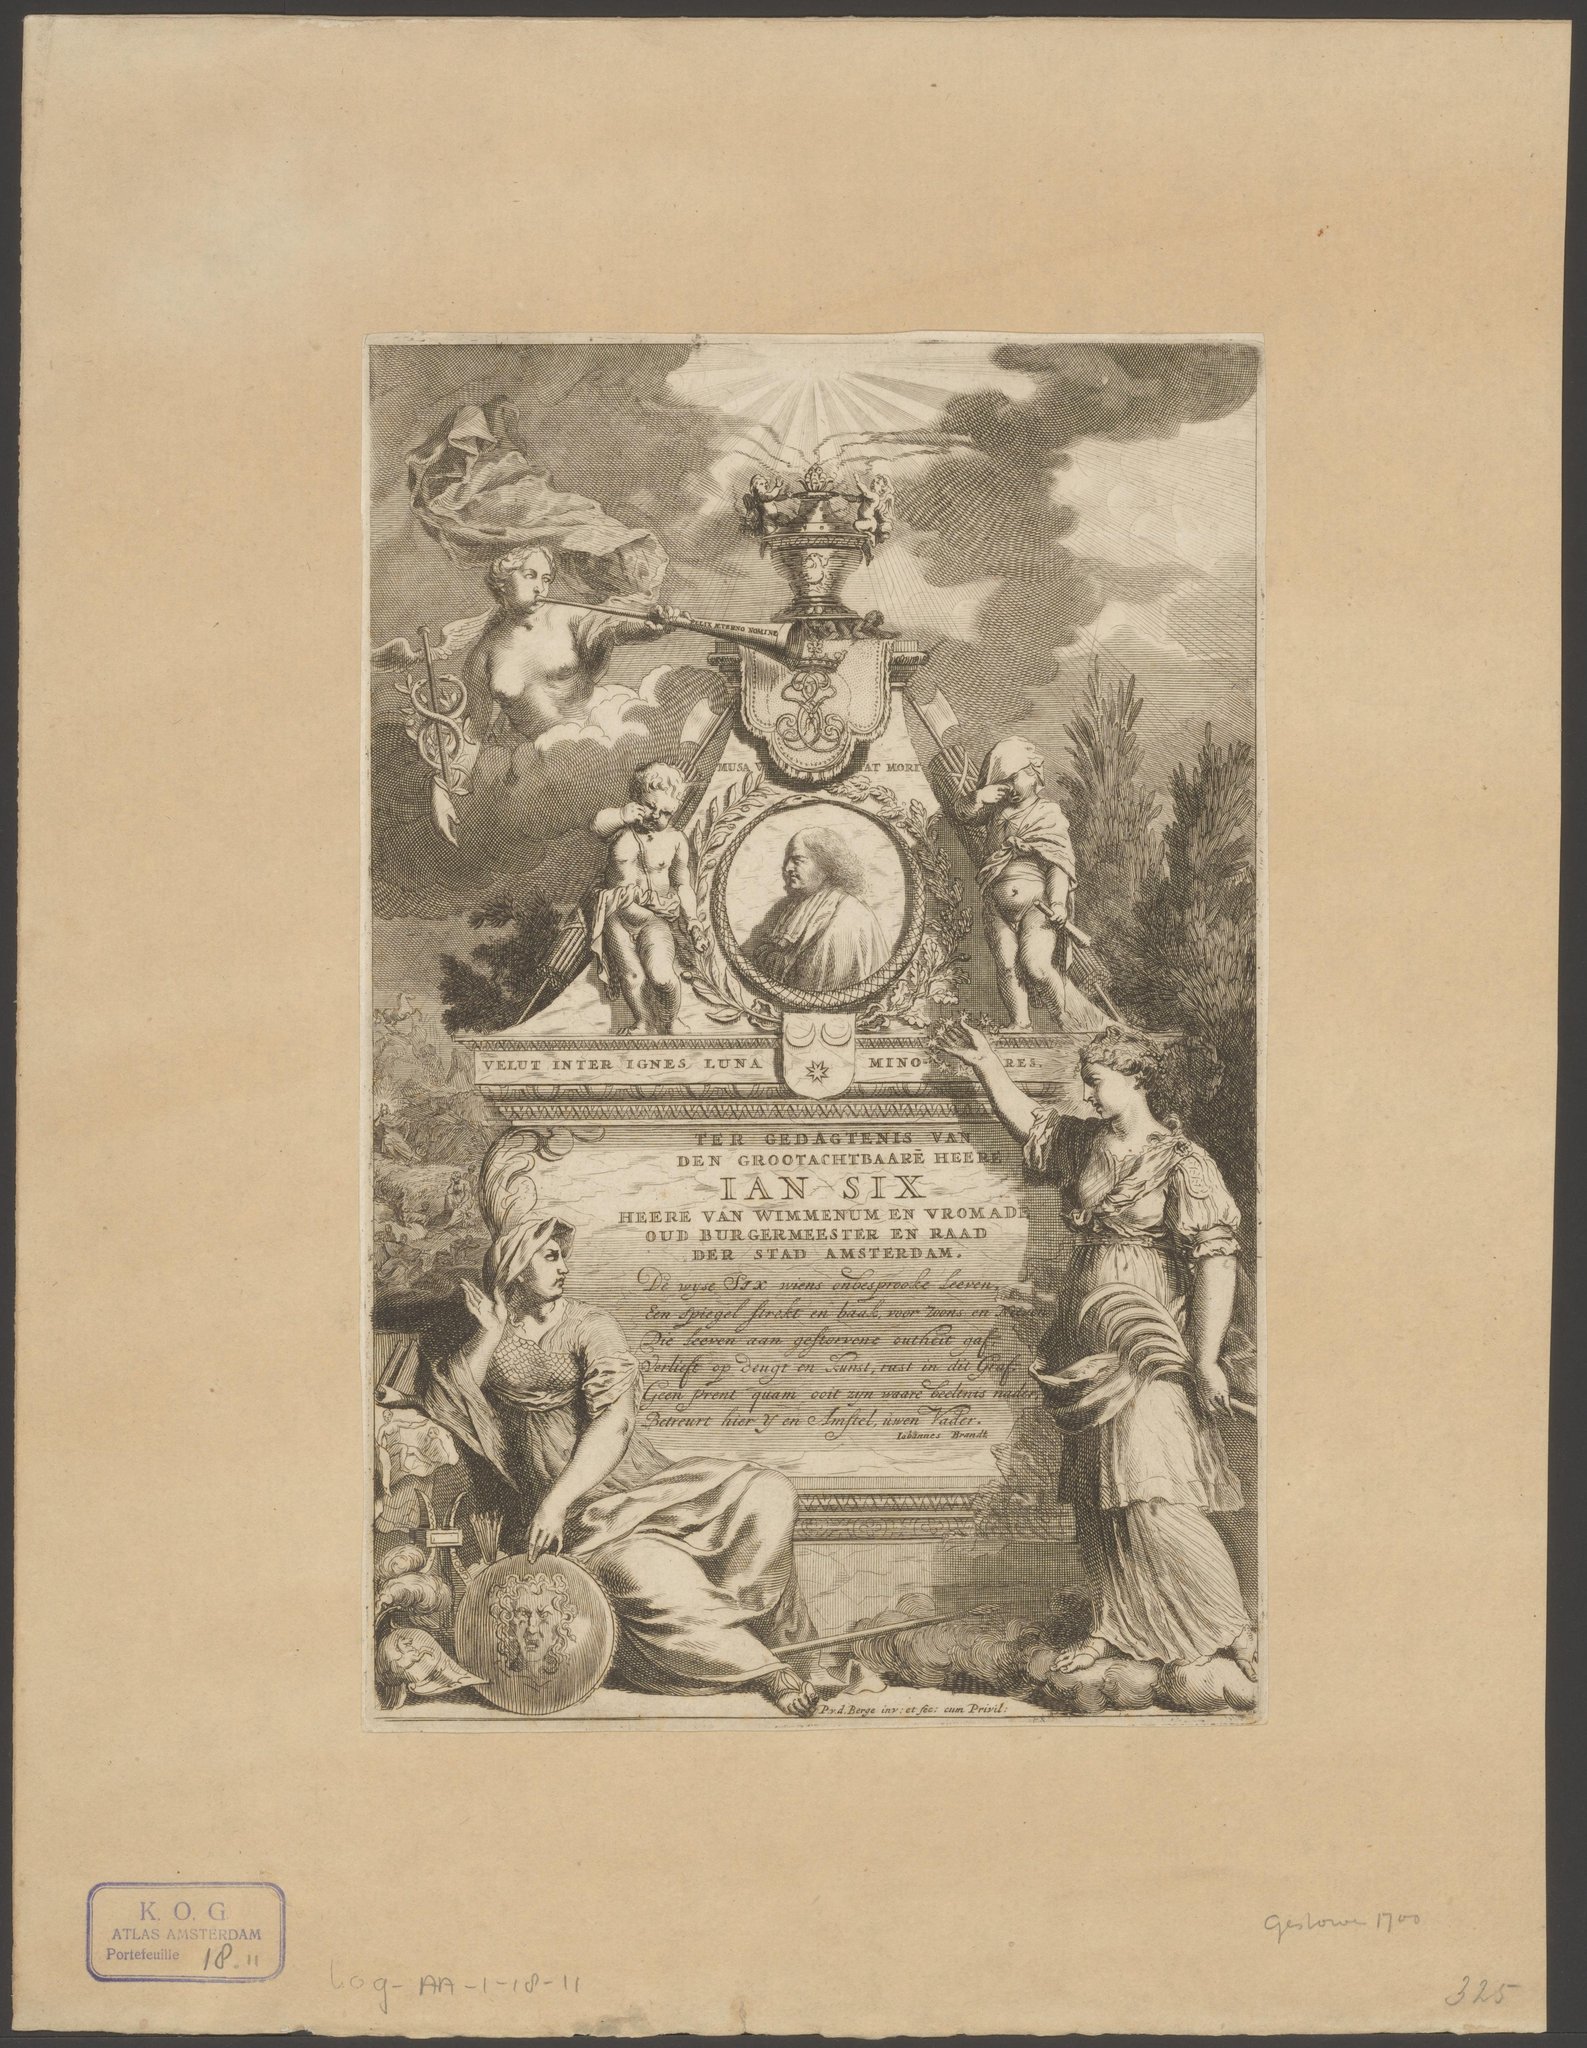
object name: print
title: Grafmonument voor Jan Six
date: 1700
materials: paper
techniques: engraving, etching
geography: amsterdam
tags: mayor, jan six (1618-1700), mayor, burgomaster, historical persons, grave-building, monumental tomb, amsterdam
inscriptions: collector's mark: ‘18.11’ Lugt 1641b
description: Onderwerpsrubriek binnen de Atlas Amsterdam: Herinneringen aan regeringsleden en hunne huisgezinnen [voor 1800].